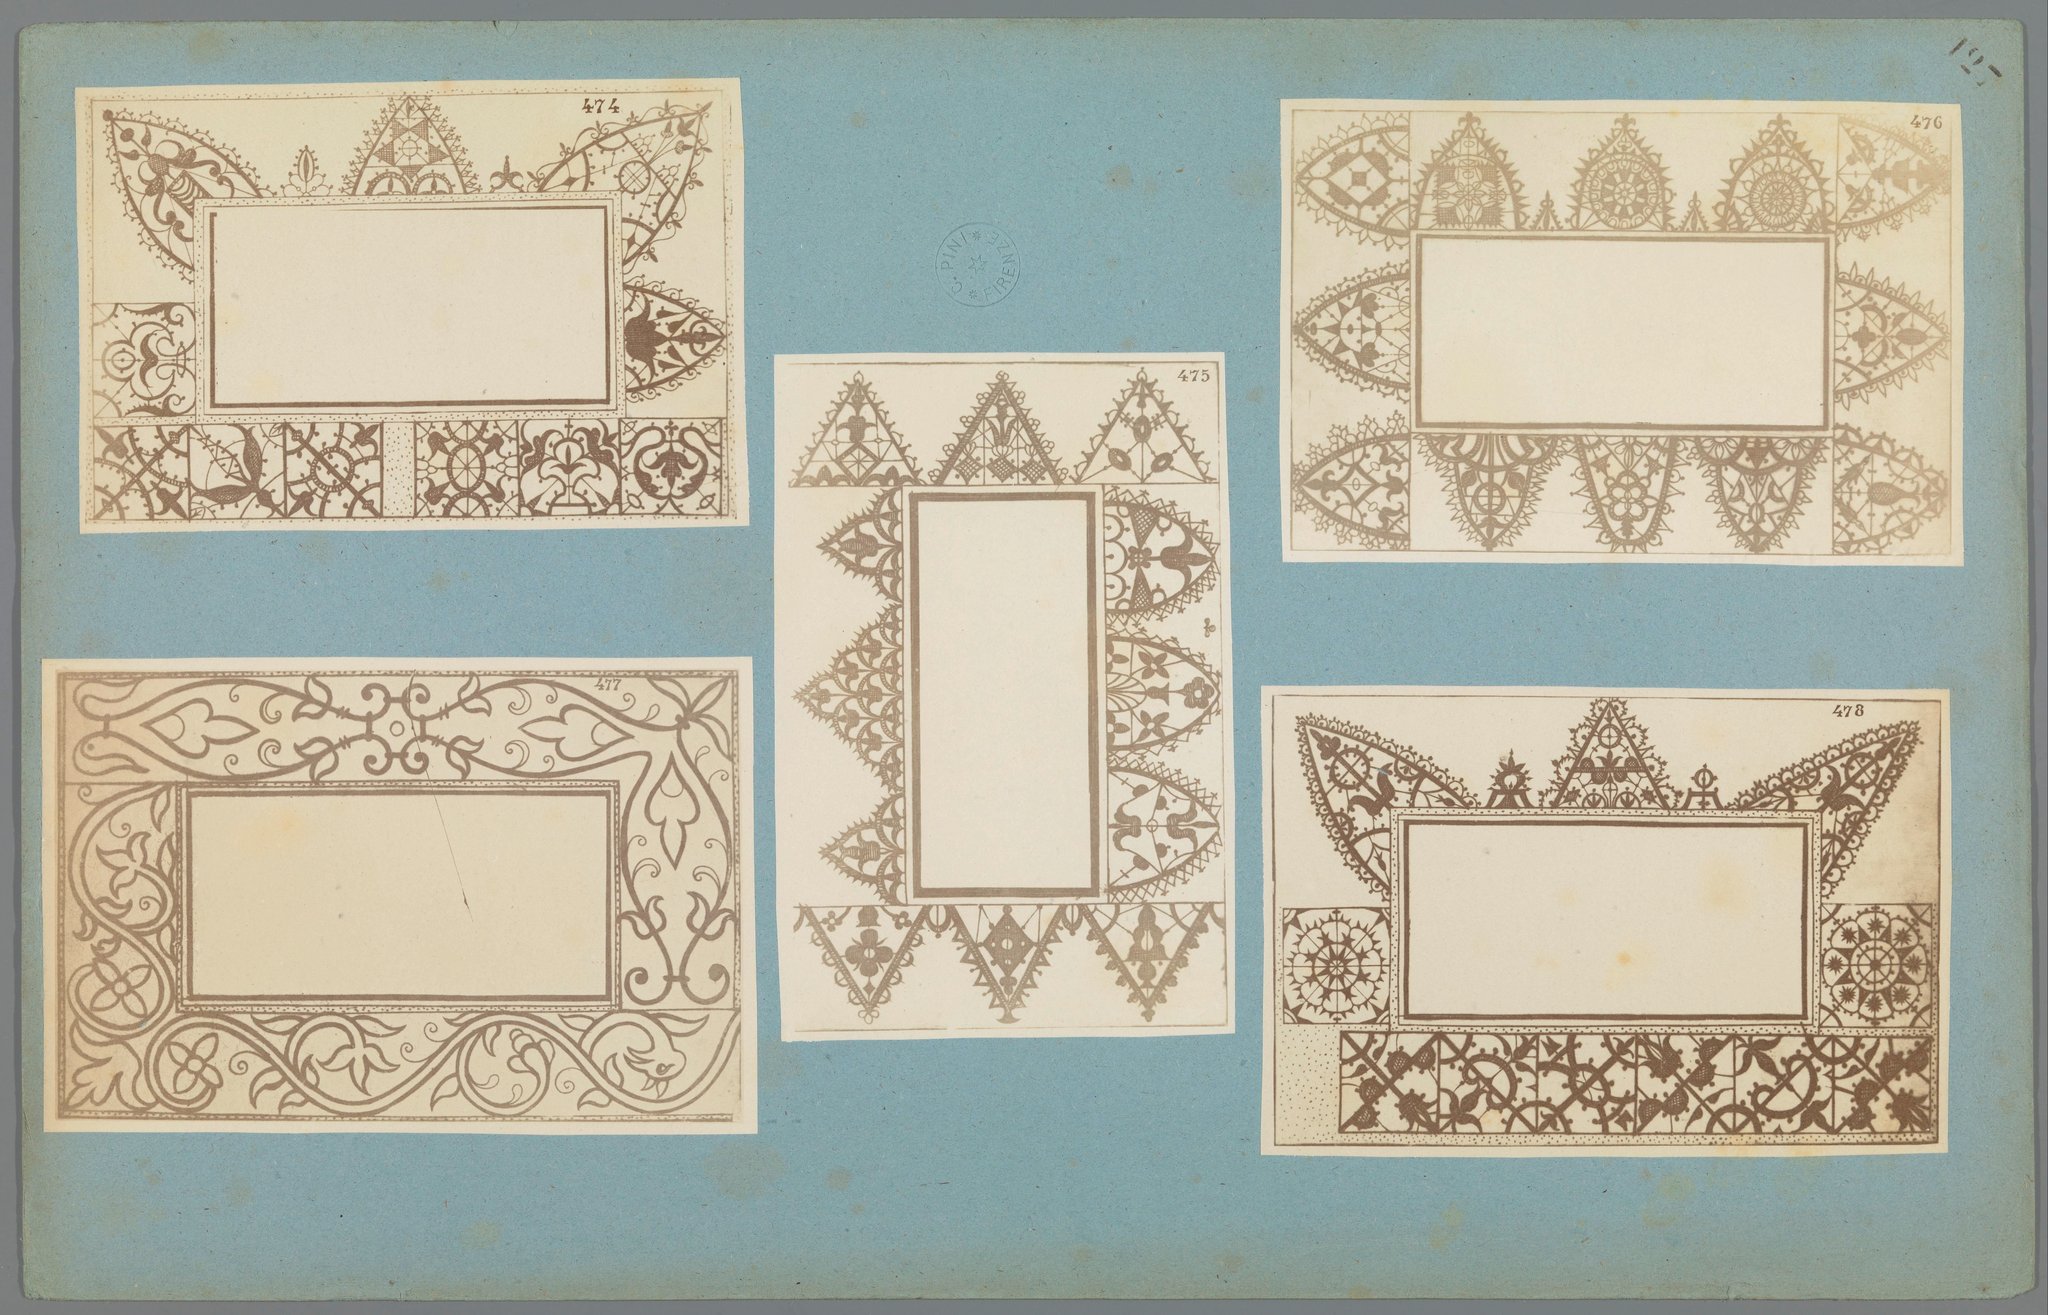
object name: reproduction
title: Vijf fotoreproducties van ornamentprenten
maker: Anonymous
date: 1875-1900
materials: cardboard, photographic support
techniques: albumen print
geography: europe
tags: foliage, tendrils, branches ~ ornament - aa - stylized, abstract interlace, knotwork ~ ornament, europe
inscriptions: number: ‘477’, number: ‘127’, number: ‘478’, number: ‘475’, number: ‘474’, name: ‘C. PINI FIRENZE’, collector's mark: Lugt 3937, number: ‘476’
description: Linksboven (474) een prent van geabstraheerde plantmotieven, linksonder (477) een prent van een bandornament met een geabstraheerd plantmotief, midden (475) een prent van geabstraheerde plantmotieven, rechtsboven (476) een prent van geabstraheerde plantmotieven, rechtsonder (478) een prent van een band met geabstraheerde plantmotieven.